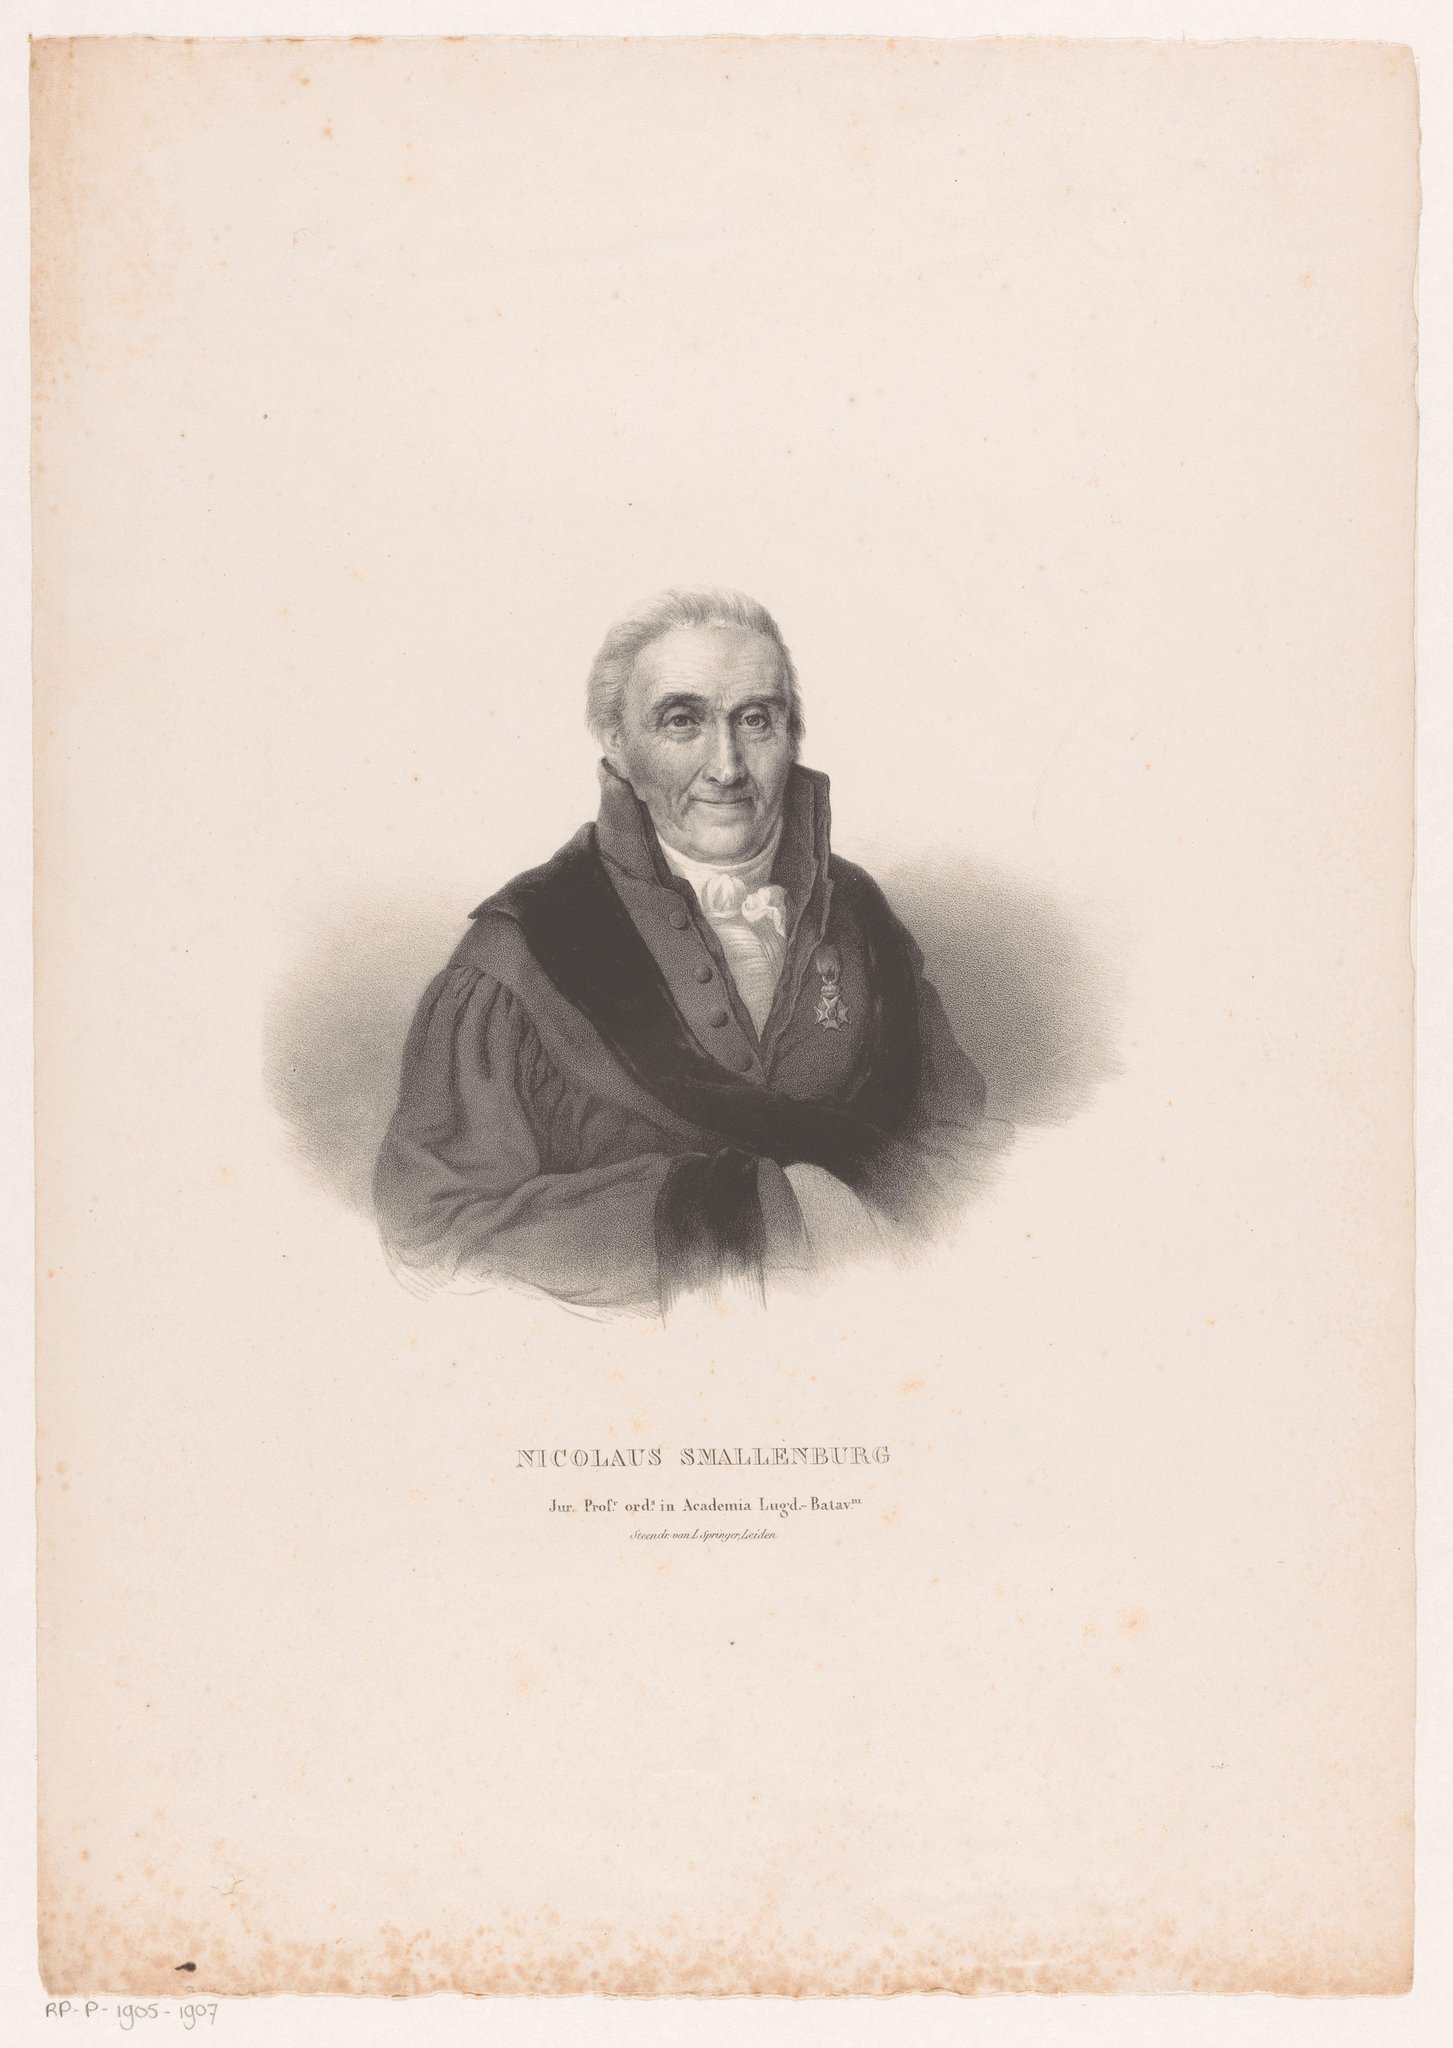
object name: print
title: Nicolaus Smallenburg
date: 1809-1853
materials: paper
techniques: lithograph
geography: leiden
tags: historical persons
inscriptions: collector's mark: Lugt 2228